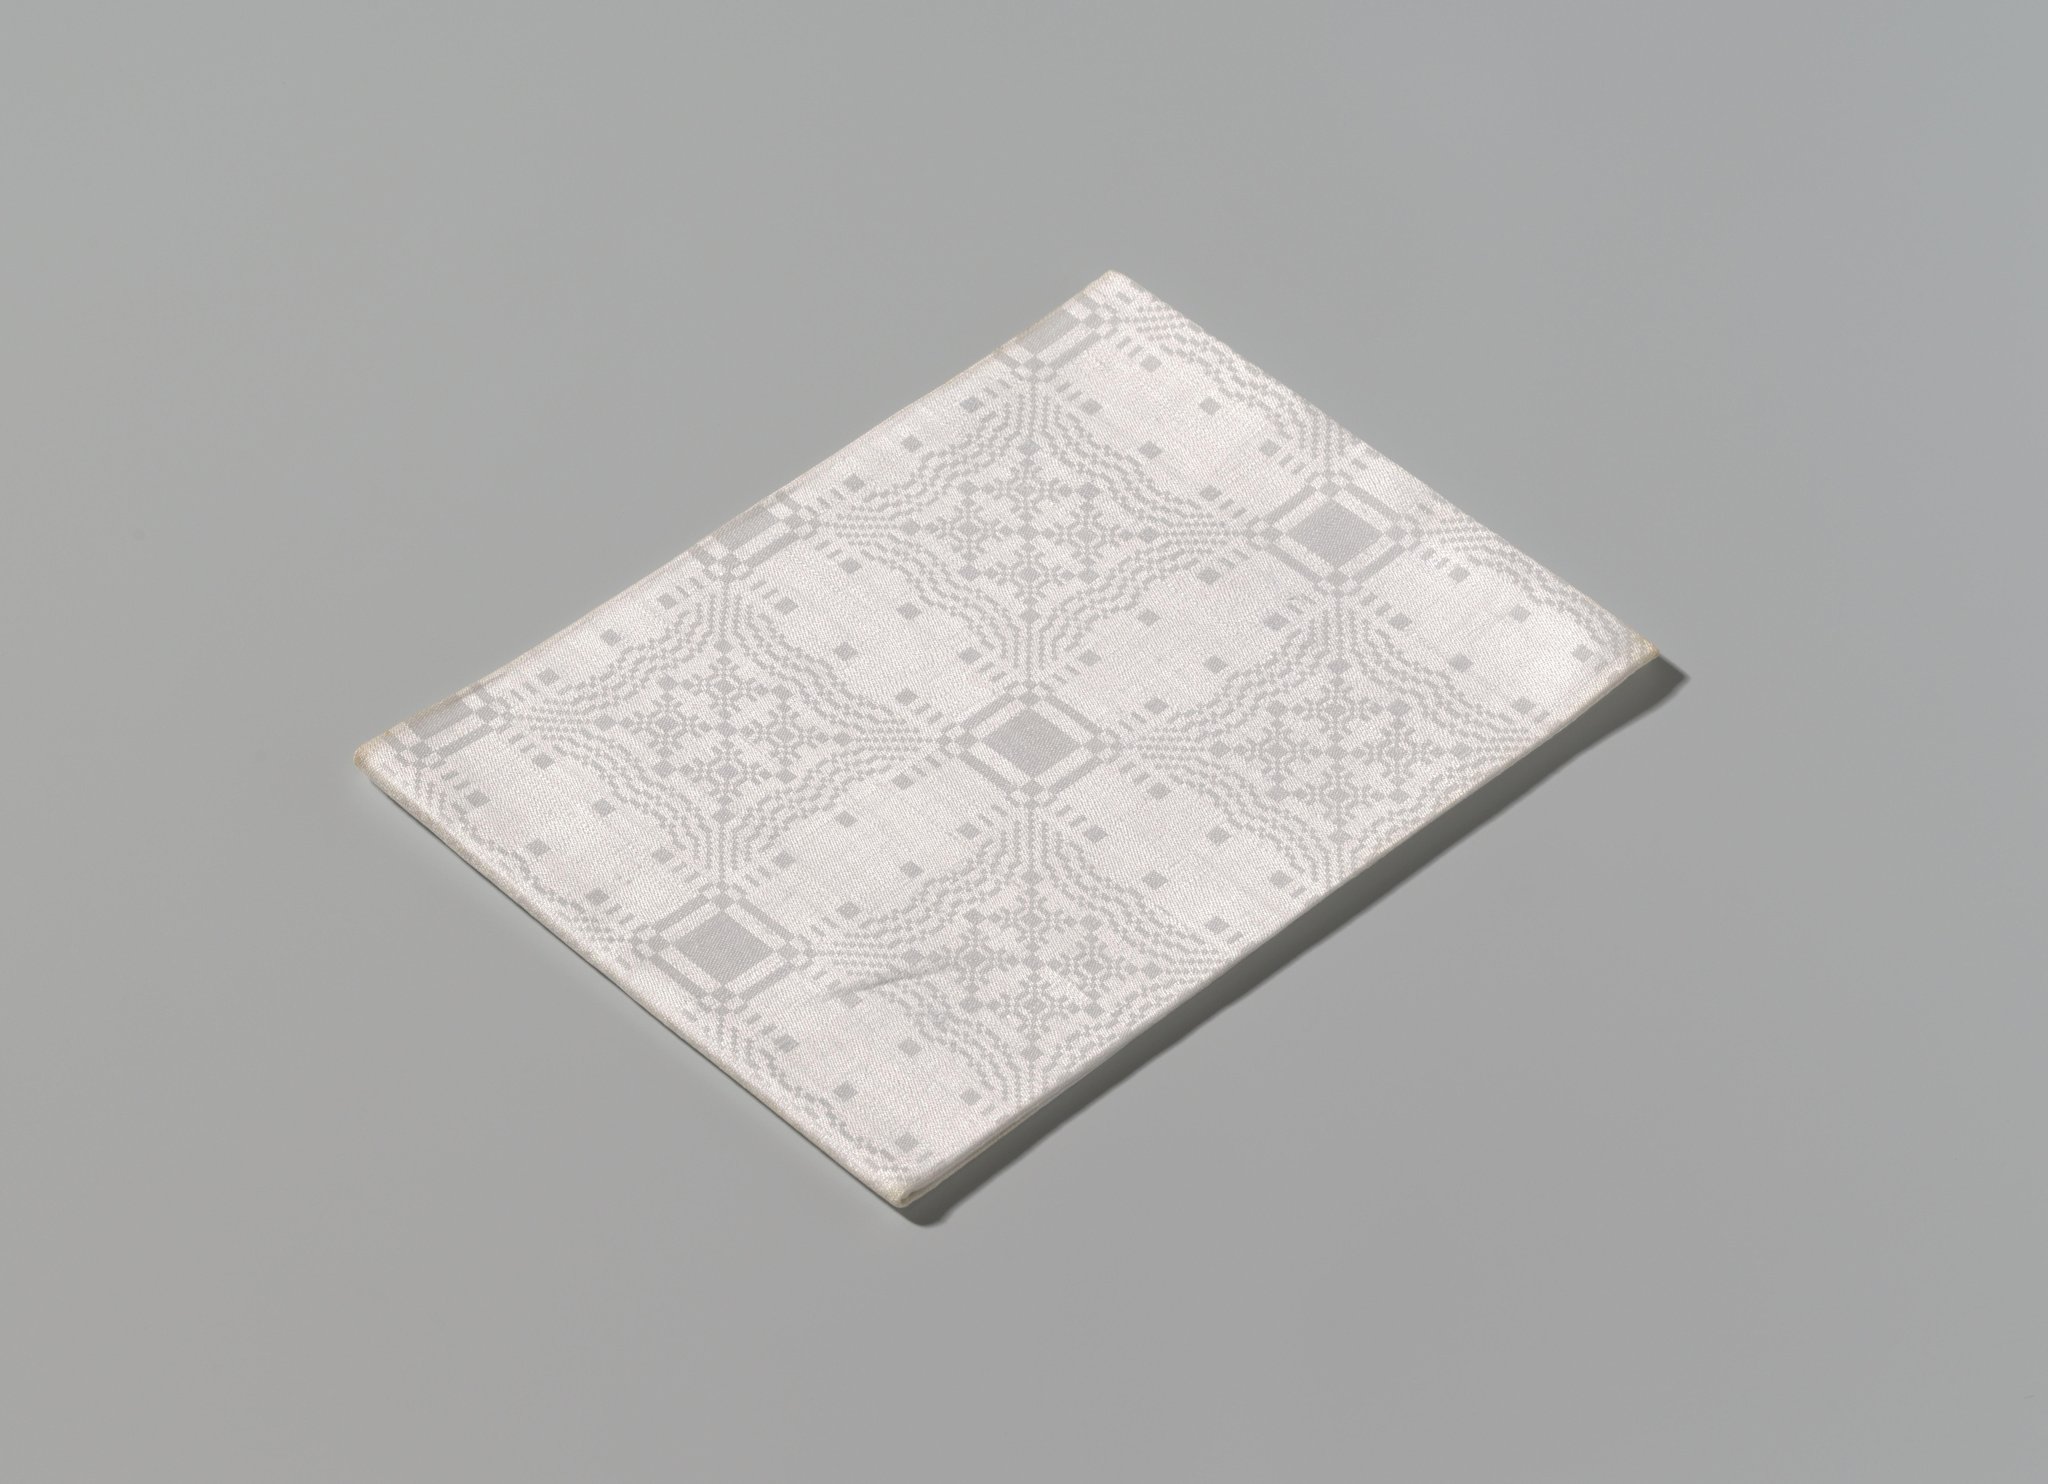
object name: napkin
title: Servet van linnen met pellenpatroon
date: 1725-1775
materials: linen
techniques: peeled fabric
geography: northern netherlands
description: wit linnen servet met pellen patroon, merk IB HW